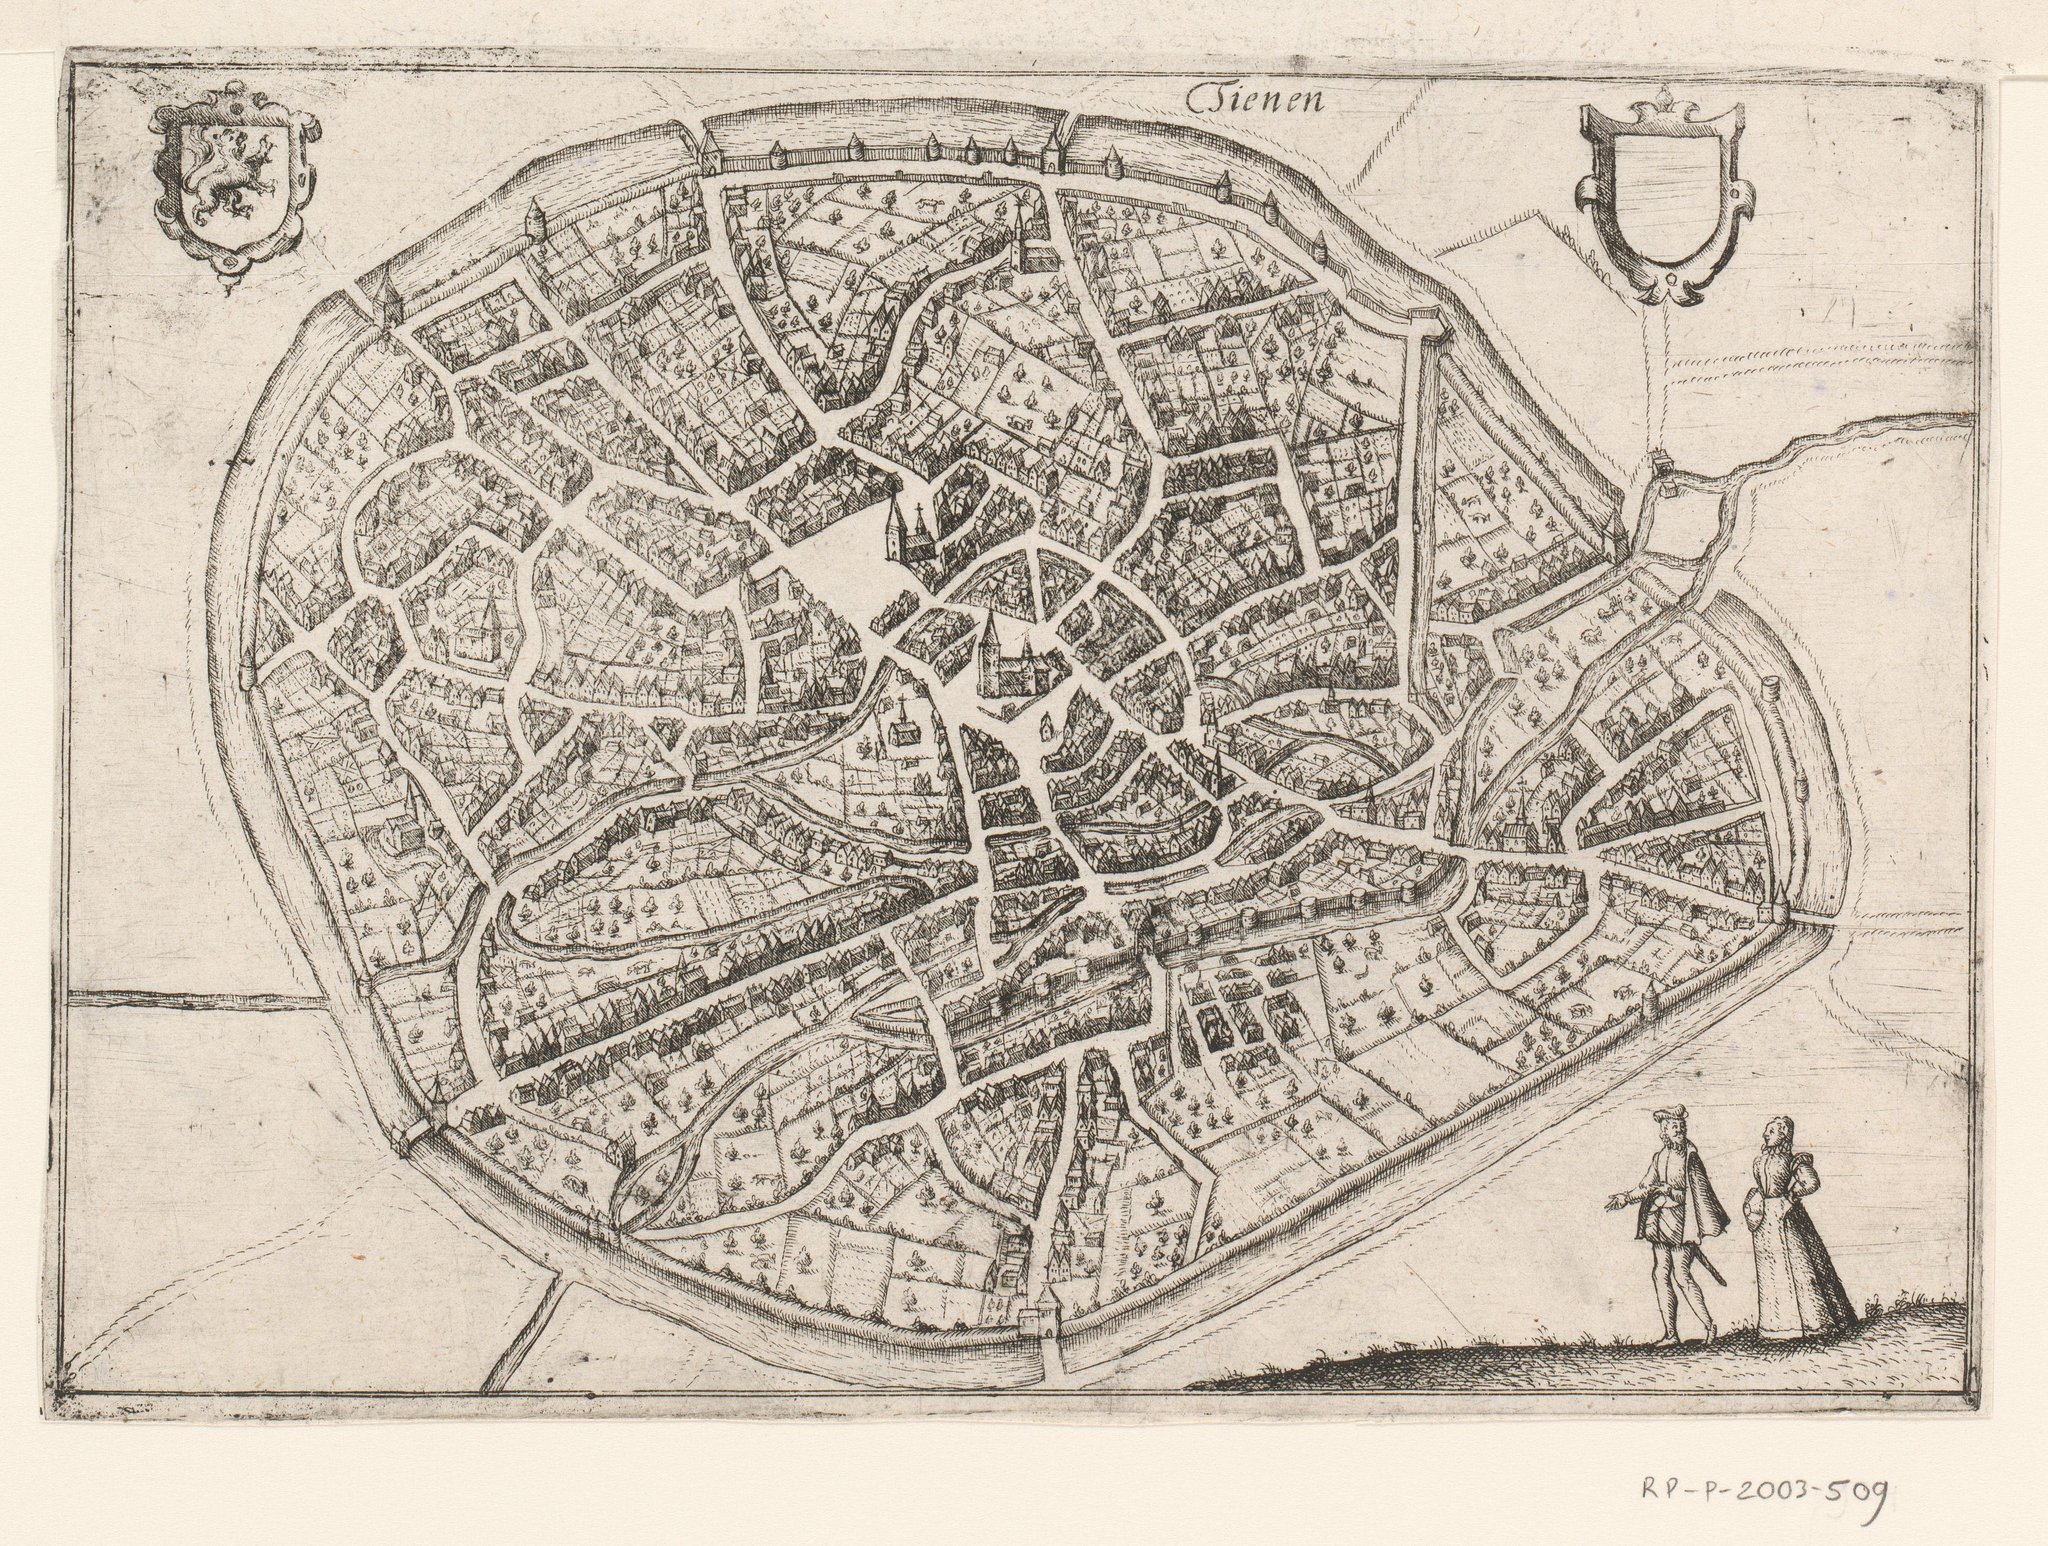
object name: print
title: Plattegronden van Bergen op Zoom en Tienen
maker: Anonymous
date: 1607-1609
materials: paper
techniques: engraving, etching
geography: northern netherlands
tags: maps of cities, bergen op zoom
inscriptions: number: ‘33’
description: Blad met twee plattegronden. Bovenaan een plattegrond van de stad Bergen op Zoom, met linksboven een cartouche met de titel en het wapen van de Luikse prins-bisschop Cornelis van Berghen, rechtsboven het stadswapen. Midden onder een vrouw en een man. Onderaan een plattegrond van de stad Tienen. Met linksboven het wapen van Brabant en rechtsboven een blanco wapen. Rechtsonder een man en een vrouw. Onderdeel van de verzameling kaarten genomen uit een latere editie van: Descrittione di tutti i Paesi Bassi van Lodovico Guicciardini.